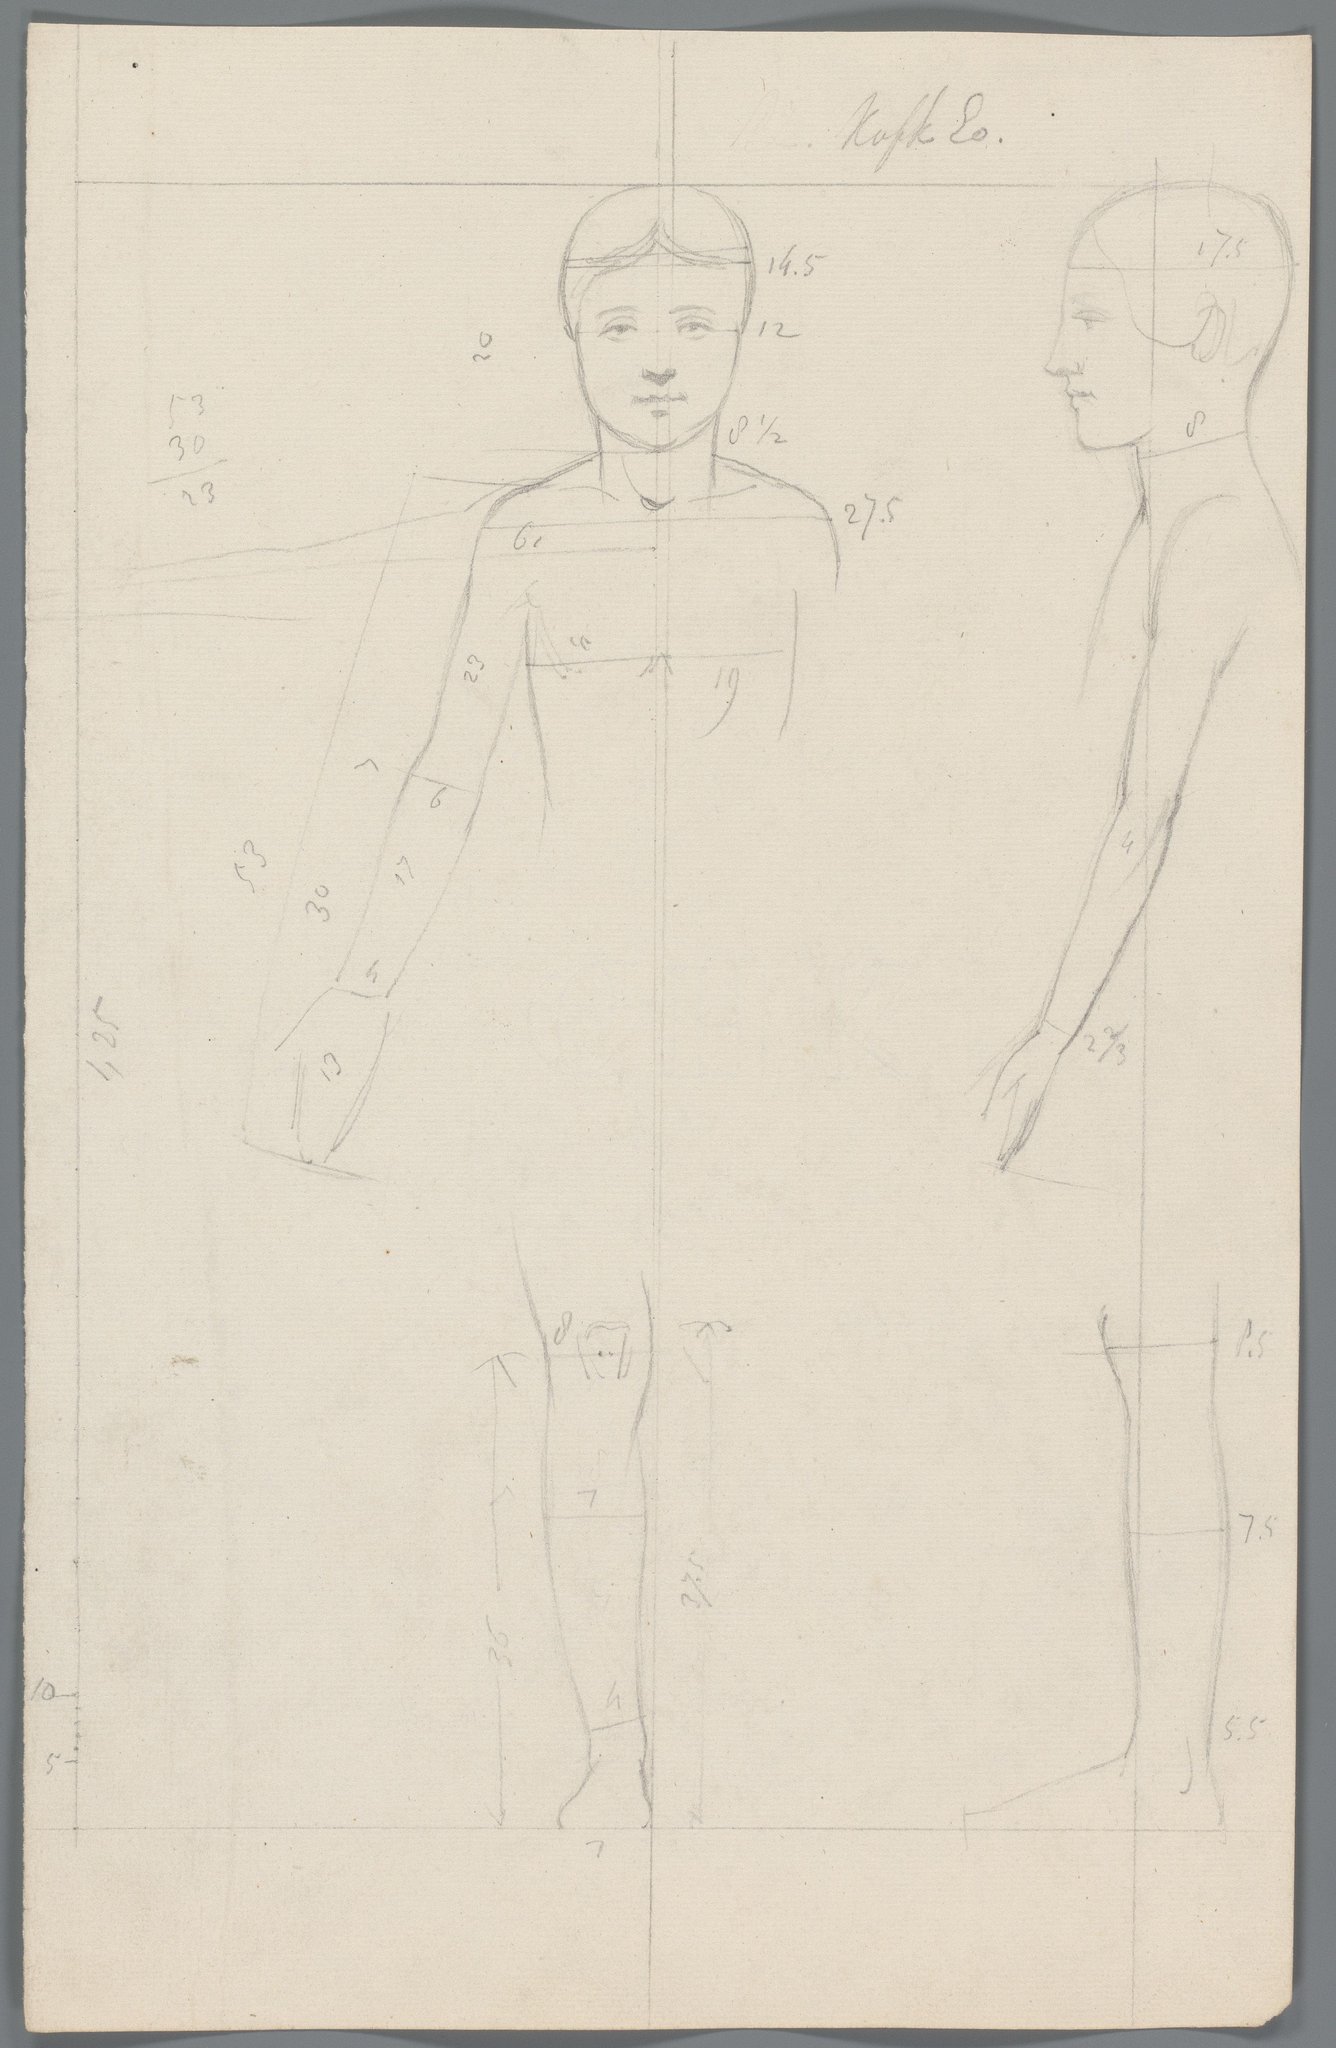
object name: drawing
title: Proportiestudie van een meisje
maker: jacobus everhardus josephus van den berg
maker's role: draughtsman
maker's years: 1802-1861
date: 1812-1861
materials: paper, pencil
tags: anatomy (non-medical), standing figure (canon, proportions) - aa - female human figure, child (at home) - aa - girl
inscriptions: inscription: ‘Kafk Eo.[?]’